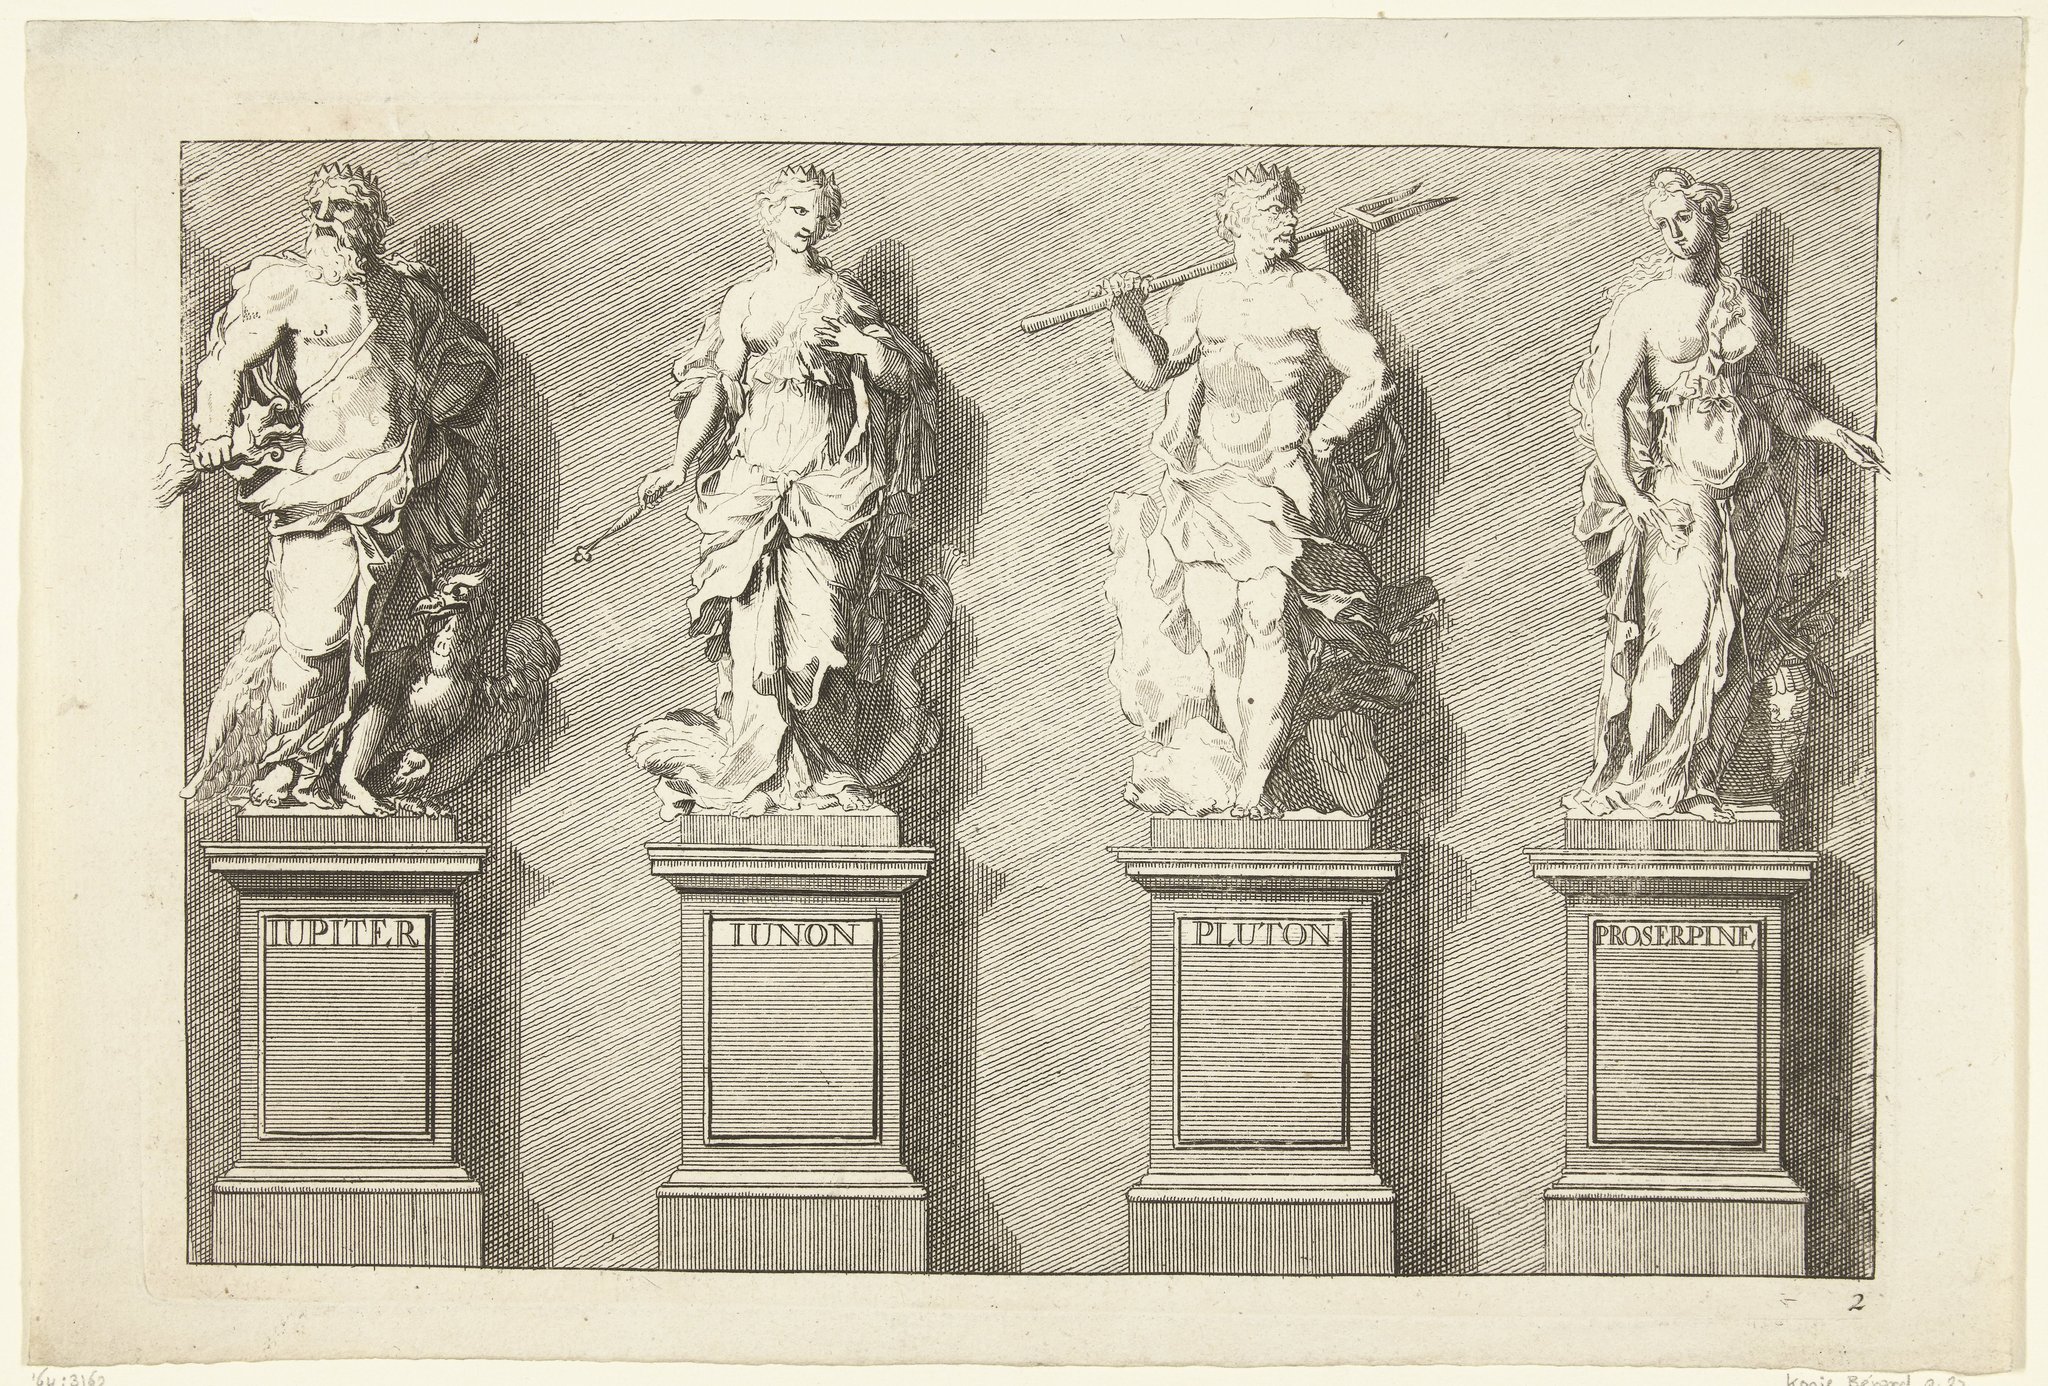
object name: print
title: Liber Statuarum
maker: Anonymous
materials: paper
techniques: etching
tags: (story of) proserpina (persephone, core), libera, (story of) juno (hera), (story of) jupiter (zeus), (story of) pluto (hades), dis pater, orcus, piece of sculpture, reproduction of a piece of sculpture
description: Vier beelden op voetstukken, met de namen op de sokkels vermeld. Kopie naar blad uit serie Liure de Statues uitgegeven door Daniel Marot.